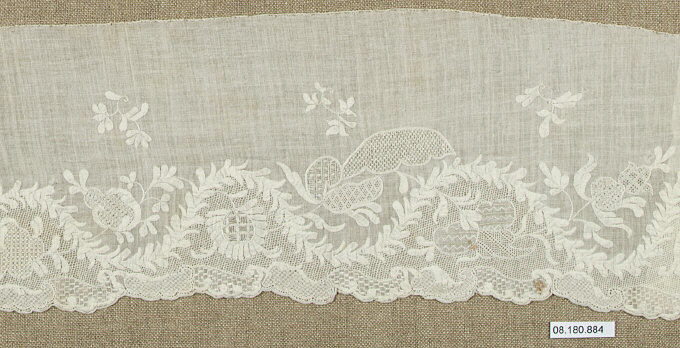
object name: band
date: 1701-1800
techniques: lace, embroidery